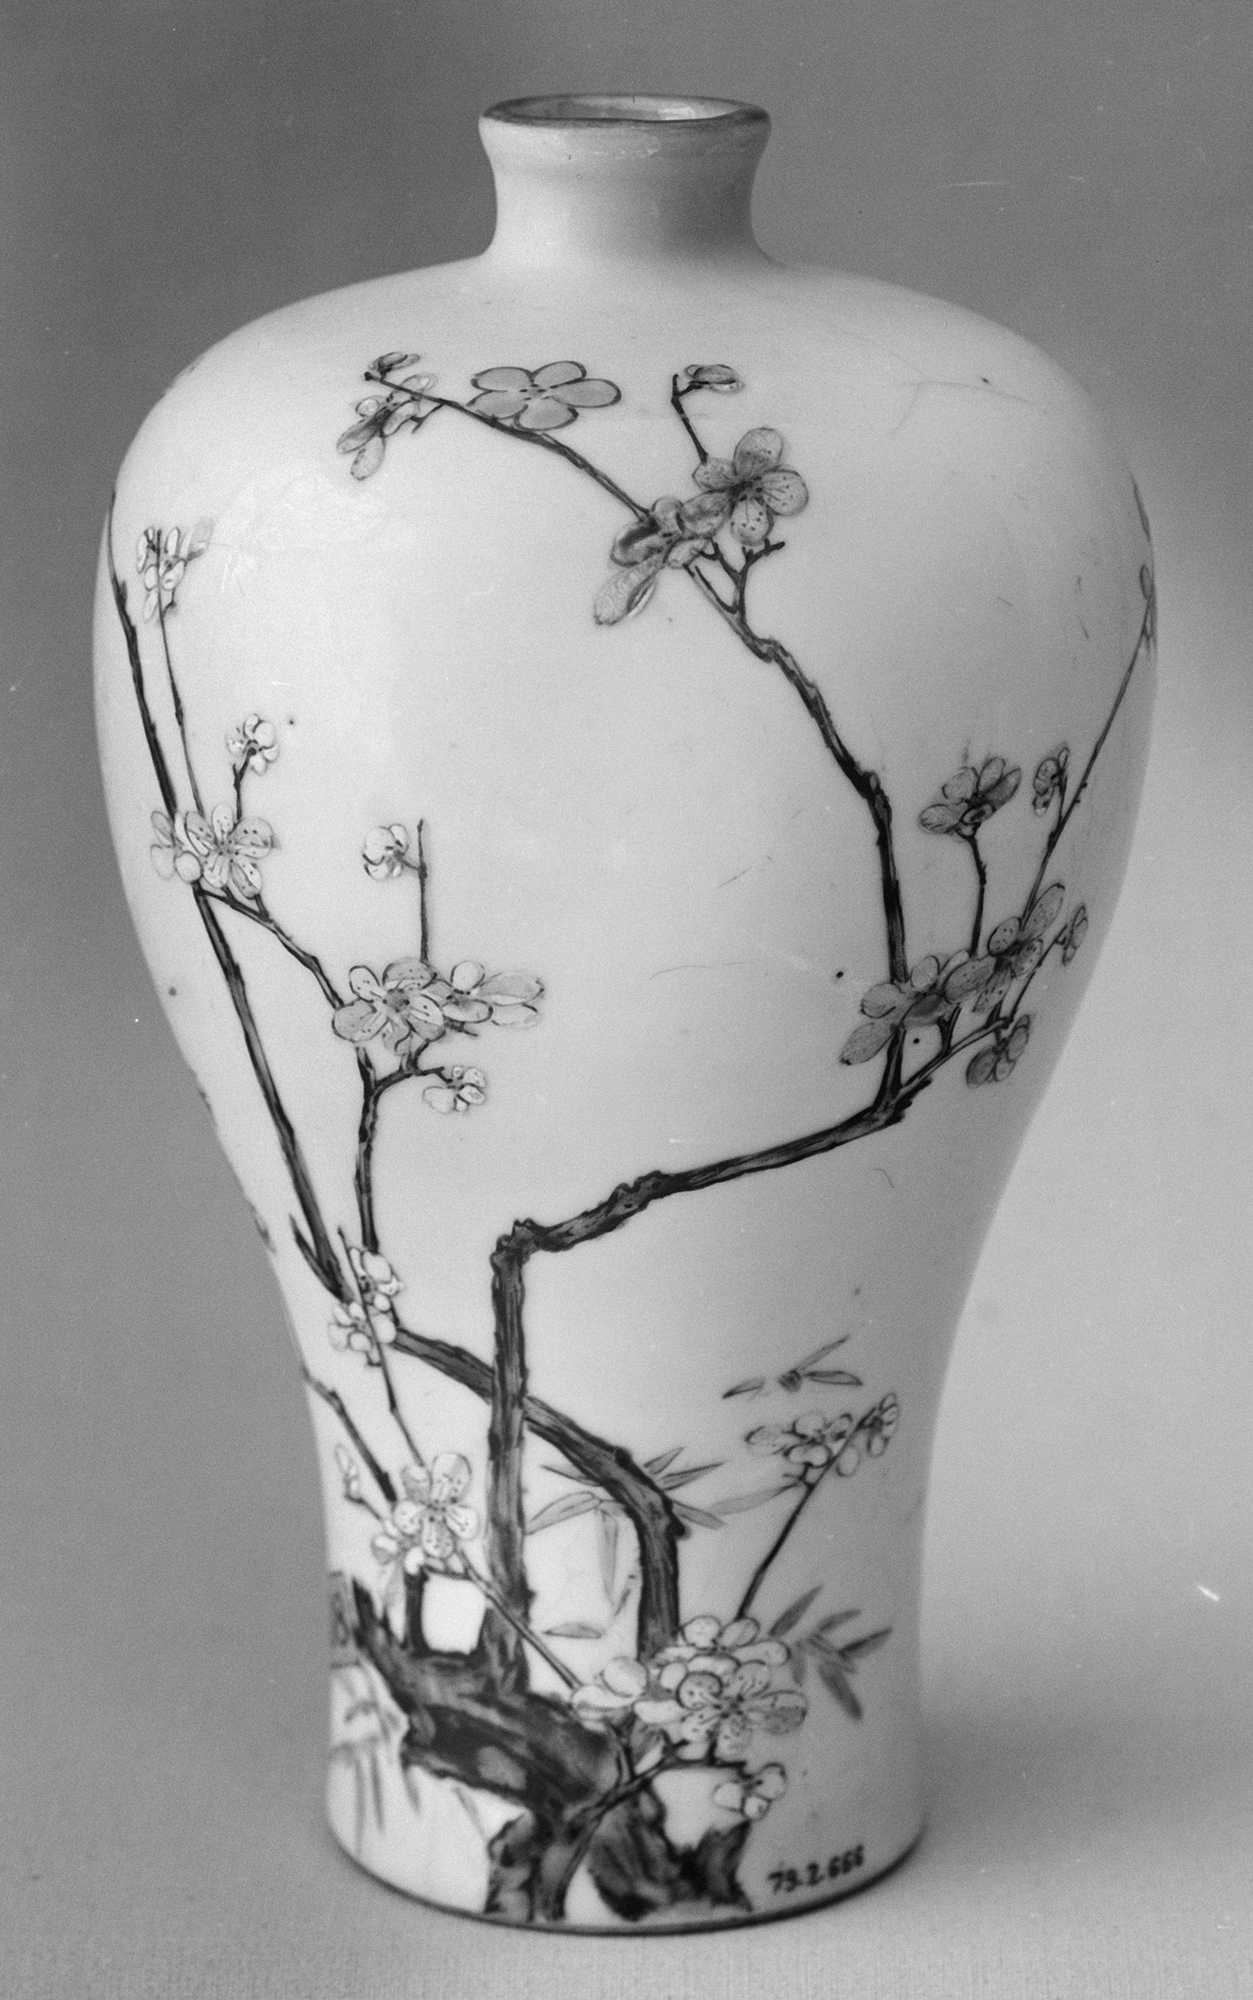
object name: vase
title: Meiping vase with plum blossoms and bamboo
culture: chinese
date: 1701-1800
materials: enamel, porcelain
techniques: overglaze, painting, polychrome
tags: flowers